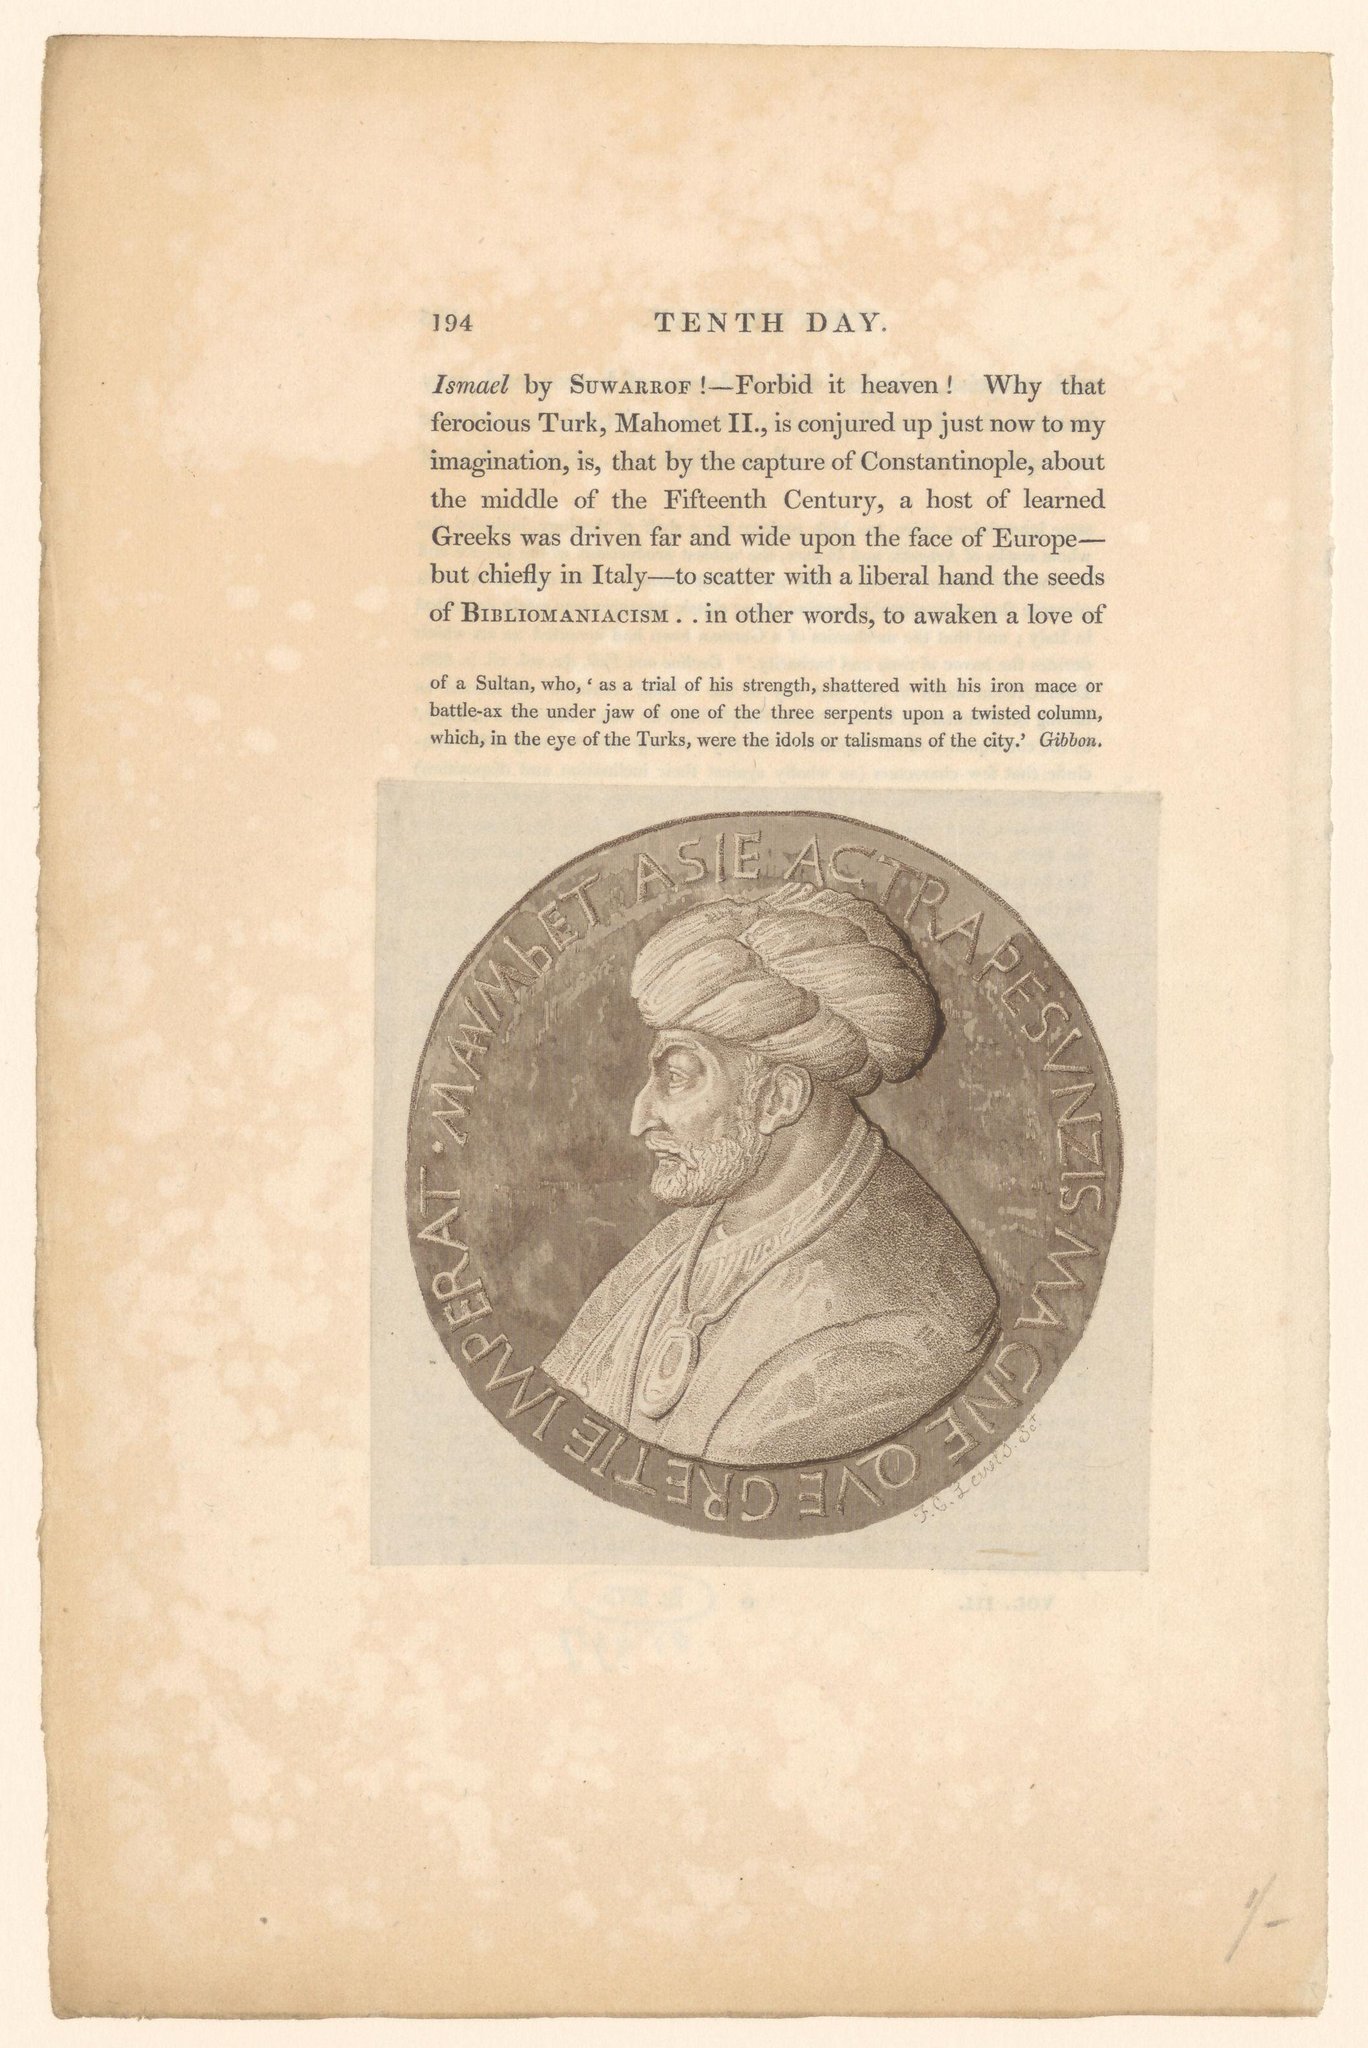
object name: book illustration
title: Portret van sultan Mehmet II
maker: frederick christian lewis (i)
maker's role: print maker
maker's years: 1779-1856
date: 1817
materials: paper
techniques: etching, letterpress printing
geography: london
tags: historical persons, ruler, sovereign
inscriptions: collector's mark: Lugt 2228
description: Prent gebruikt in: Dibdin, T.F. The Bibliographical Decameron; Or, Ten Days Pleasant Discourse Upon Illuminated Manuscripts. Londen: W. Bulmer & Co, 1917, dl.3, p. 194.